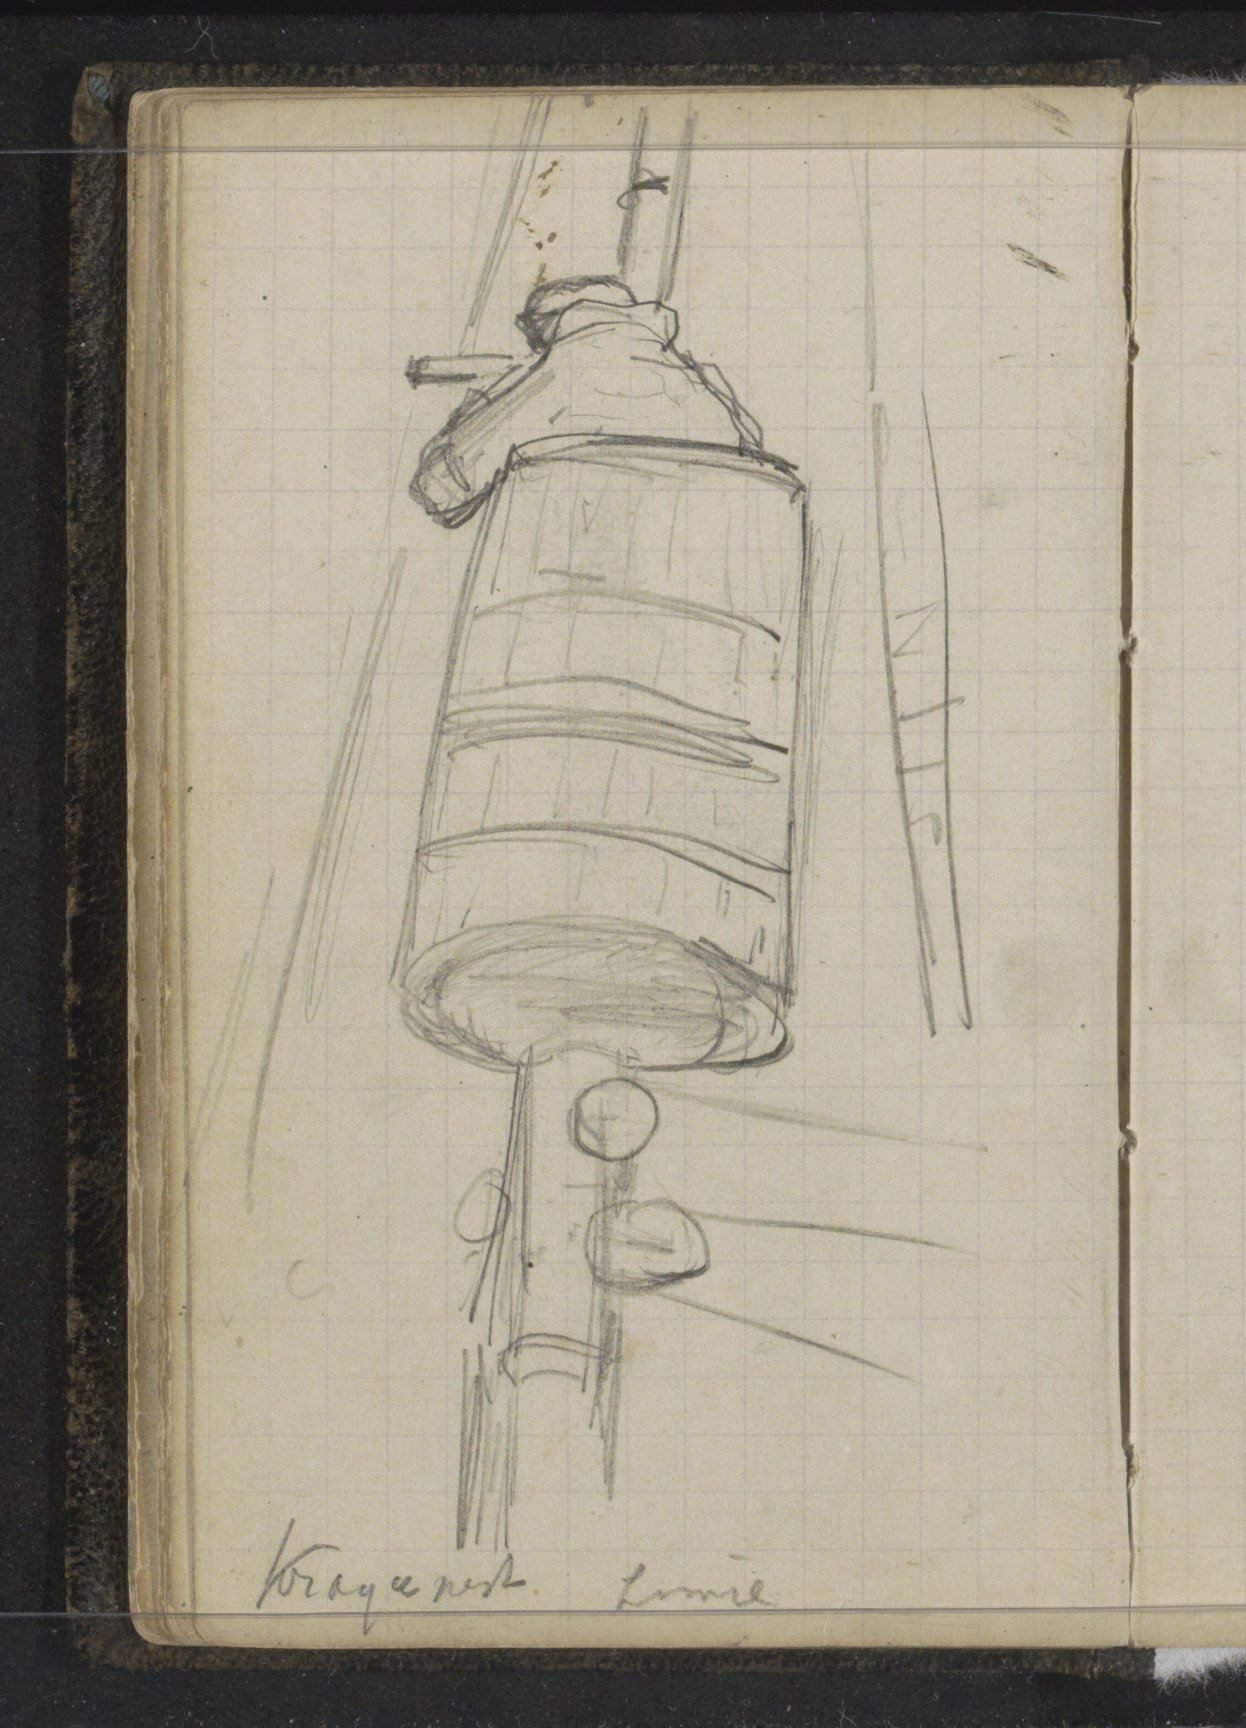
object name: sketchbook leaf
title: Bemanningslid (Lowie) in het kraaiennest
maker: louis apol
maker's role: draughtsman, painter, print maker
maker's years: 1850-1936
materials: pencil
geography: barentsz sea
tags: look-out in the crow's nest, sailor, adult man (+ standing)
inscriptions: annotation: ‘Krayenest. Lowie’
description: Hij kijkt door een verrekijker (monokijker). Blad 20 verso uit een schetsboek met 110 bladen betekend tijdens de expeditie naar Nova Zembla in 1880.